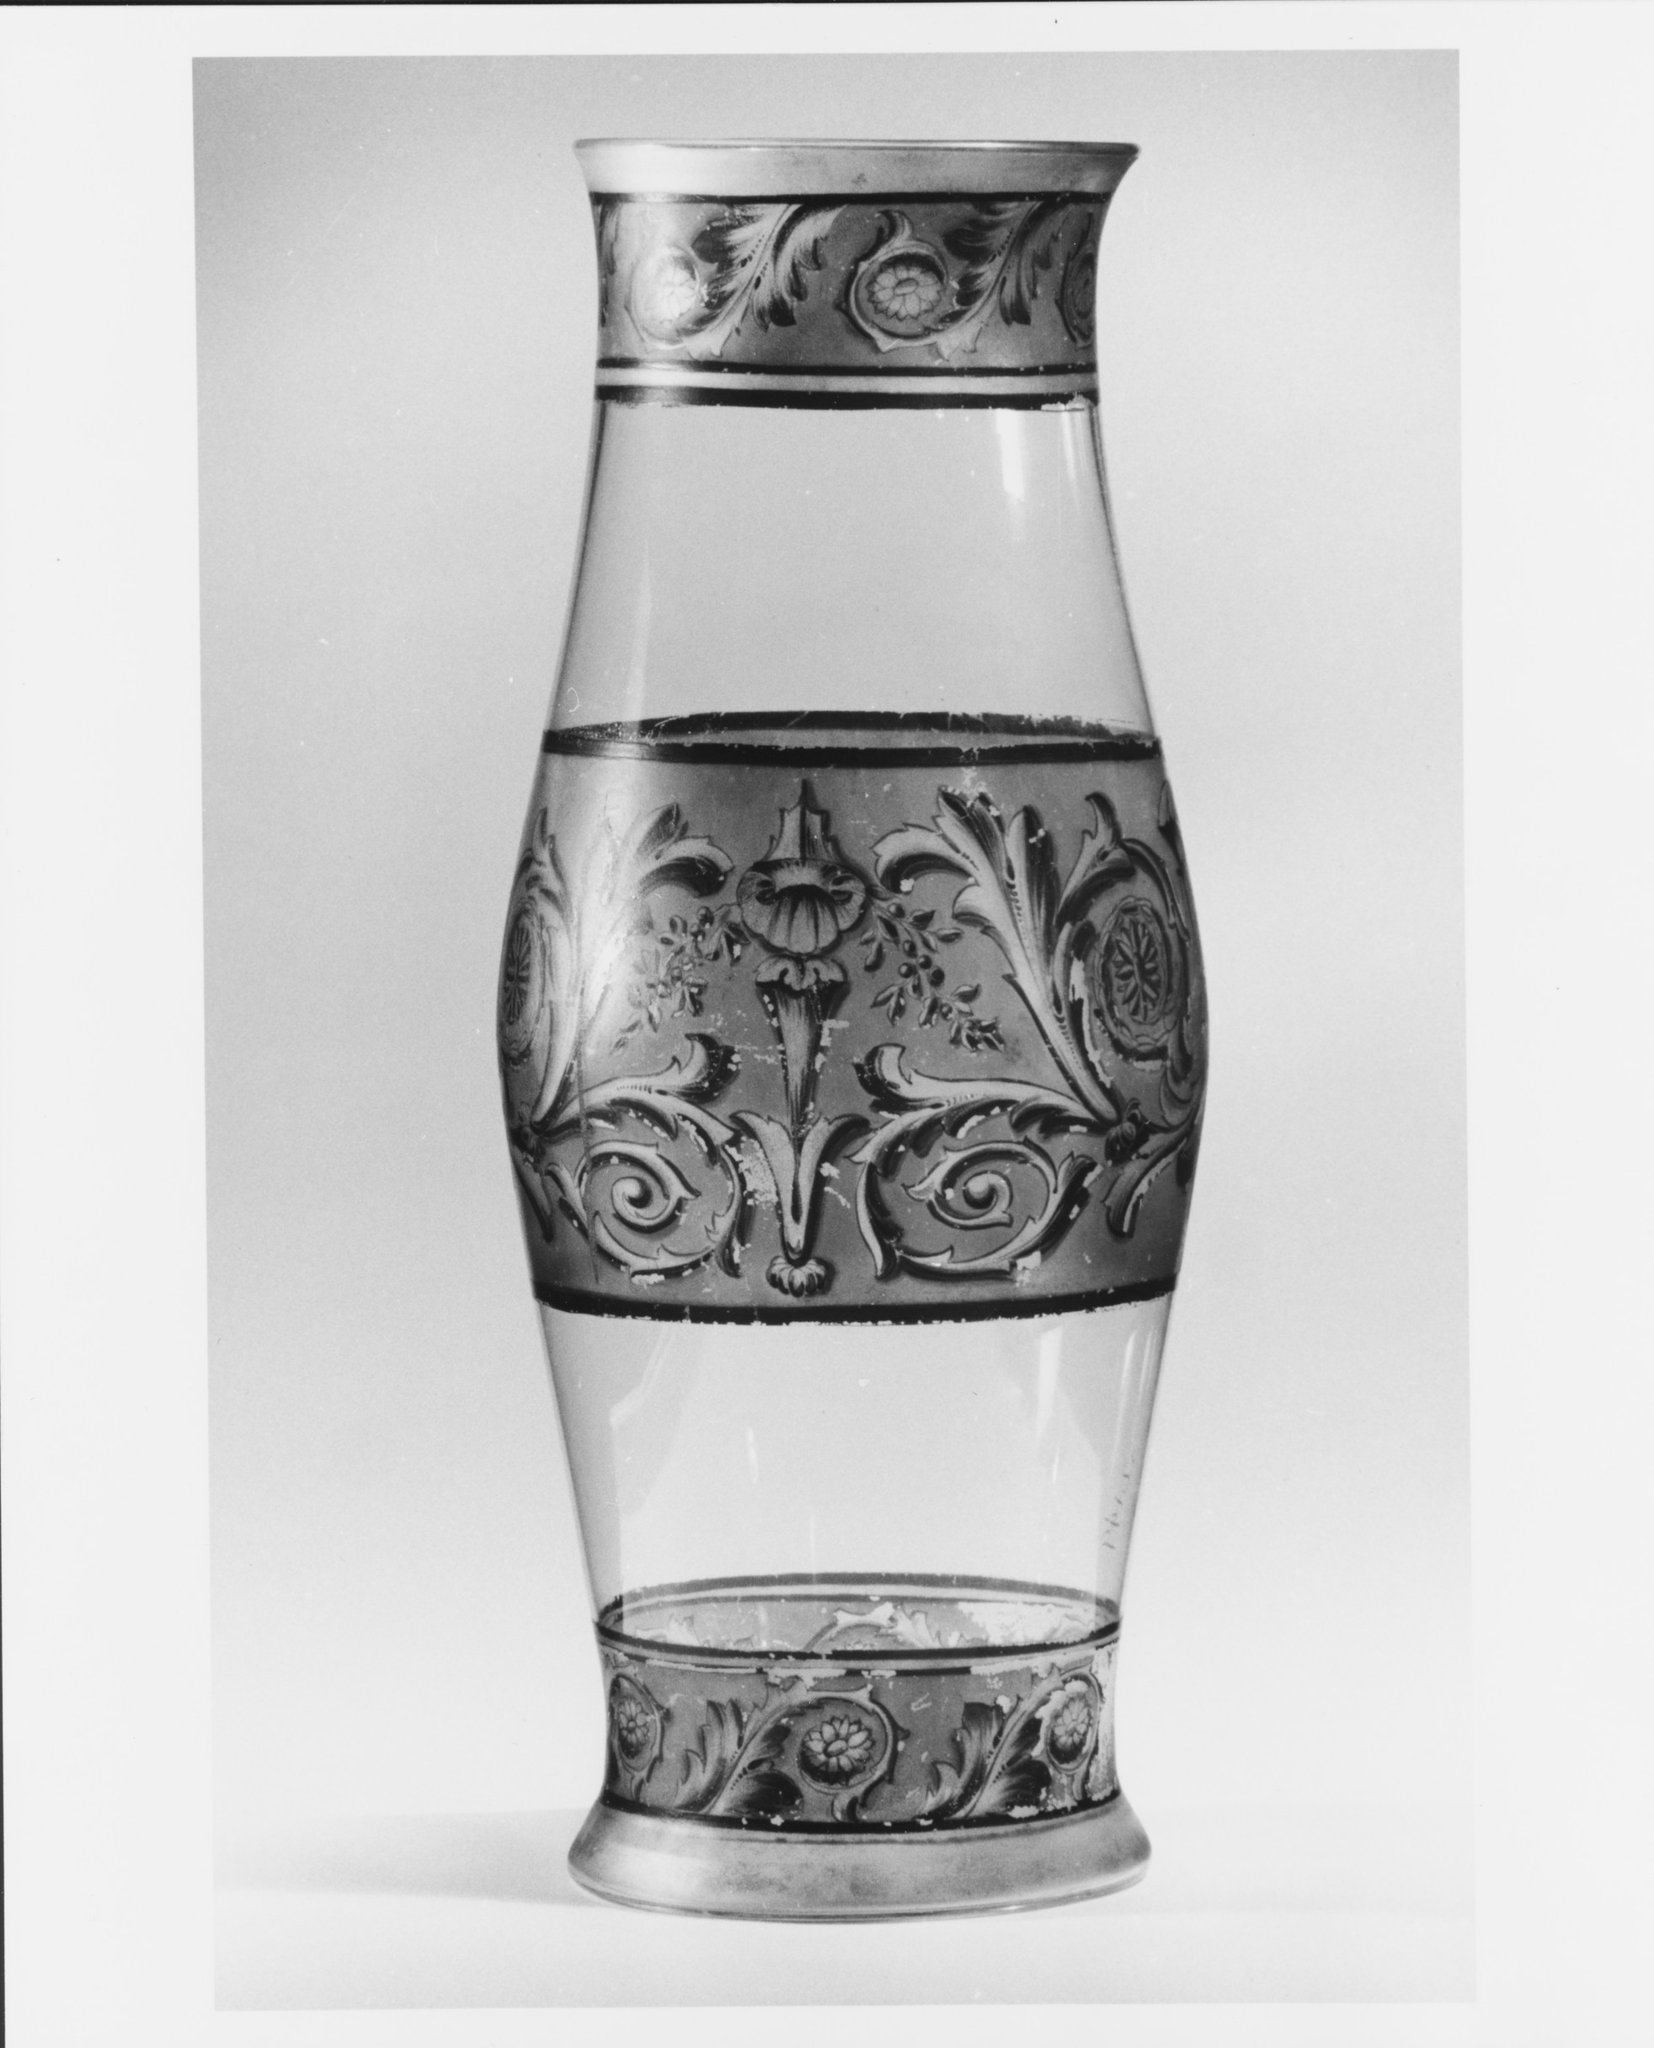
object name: hurricane shade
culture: american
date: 1825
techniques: glassblowing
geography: united states